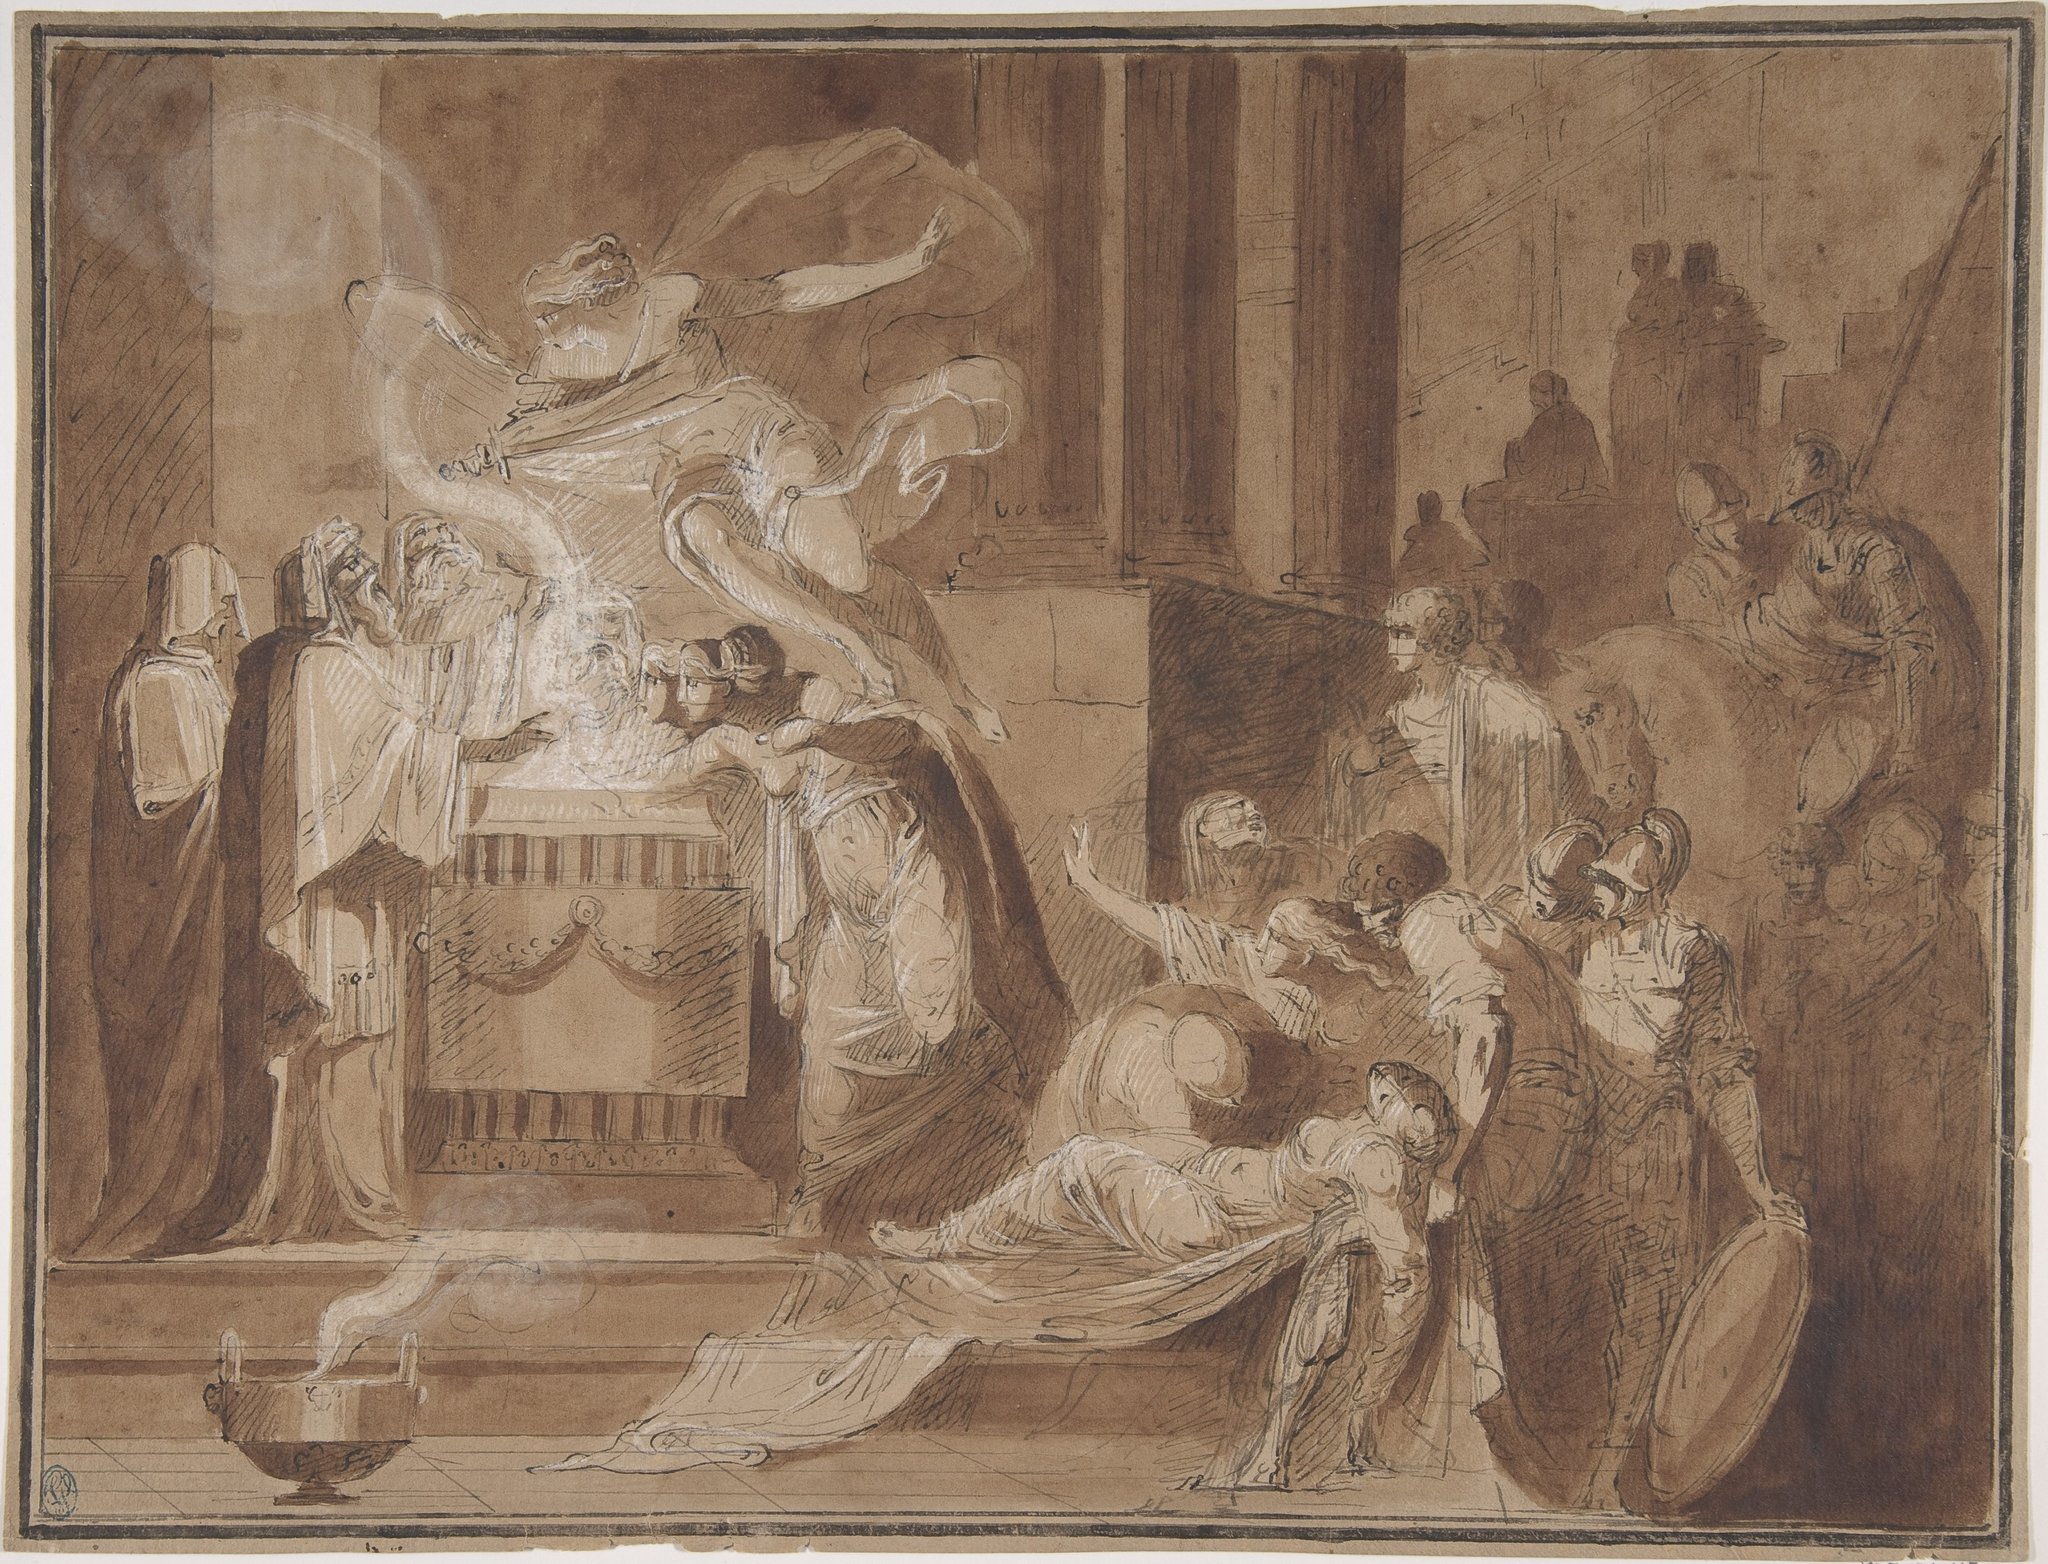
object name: drawing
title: A Scene of Sacrifice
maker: anonymous, french, 18th century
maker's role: artist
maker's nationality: french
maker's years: 1700-1800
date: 1701-1800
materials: ink, paper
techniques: brush, heightening, pen, wash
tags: soldiers,shields,men,women